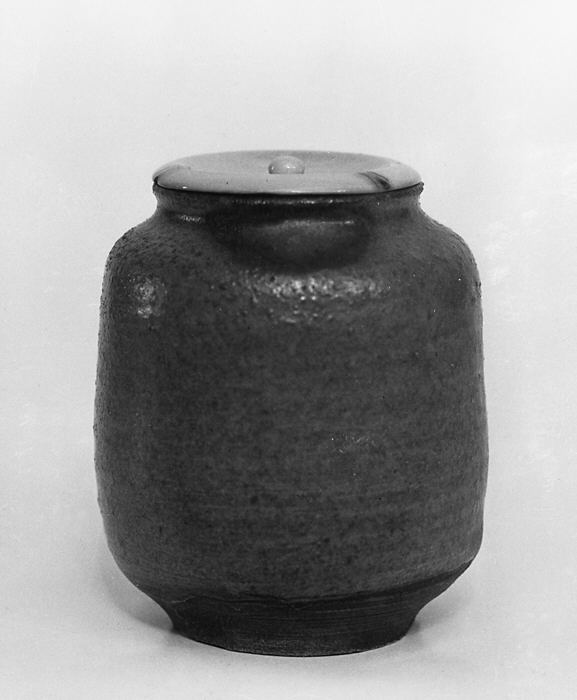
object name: tea jar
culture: japanese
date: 1701-1800